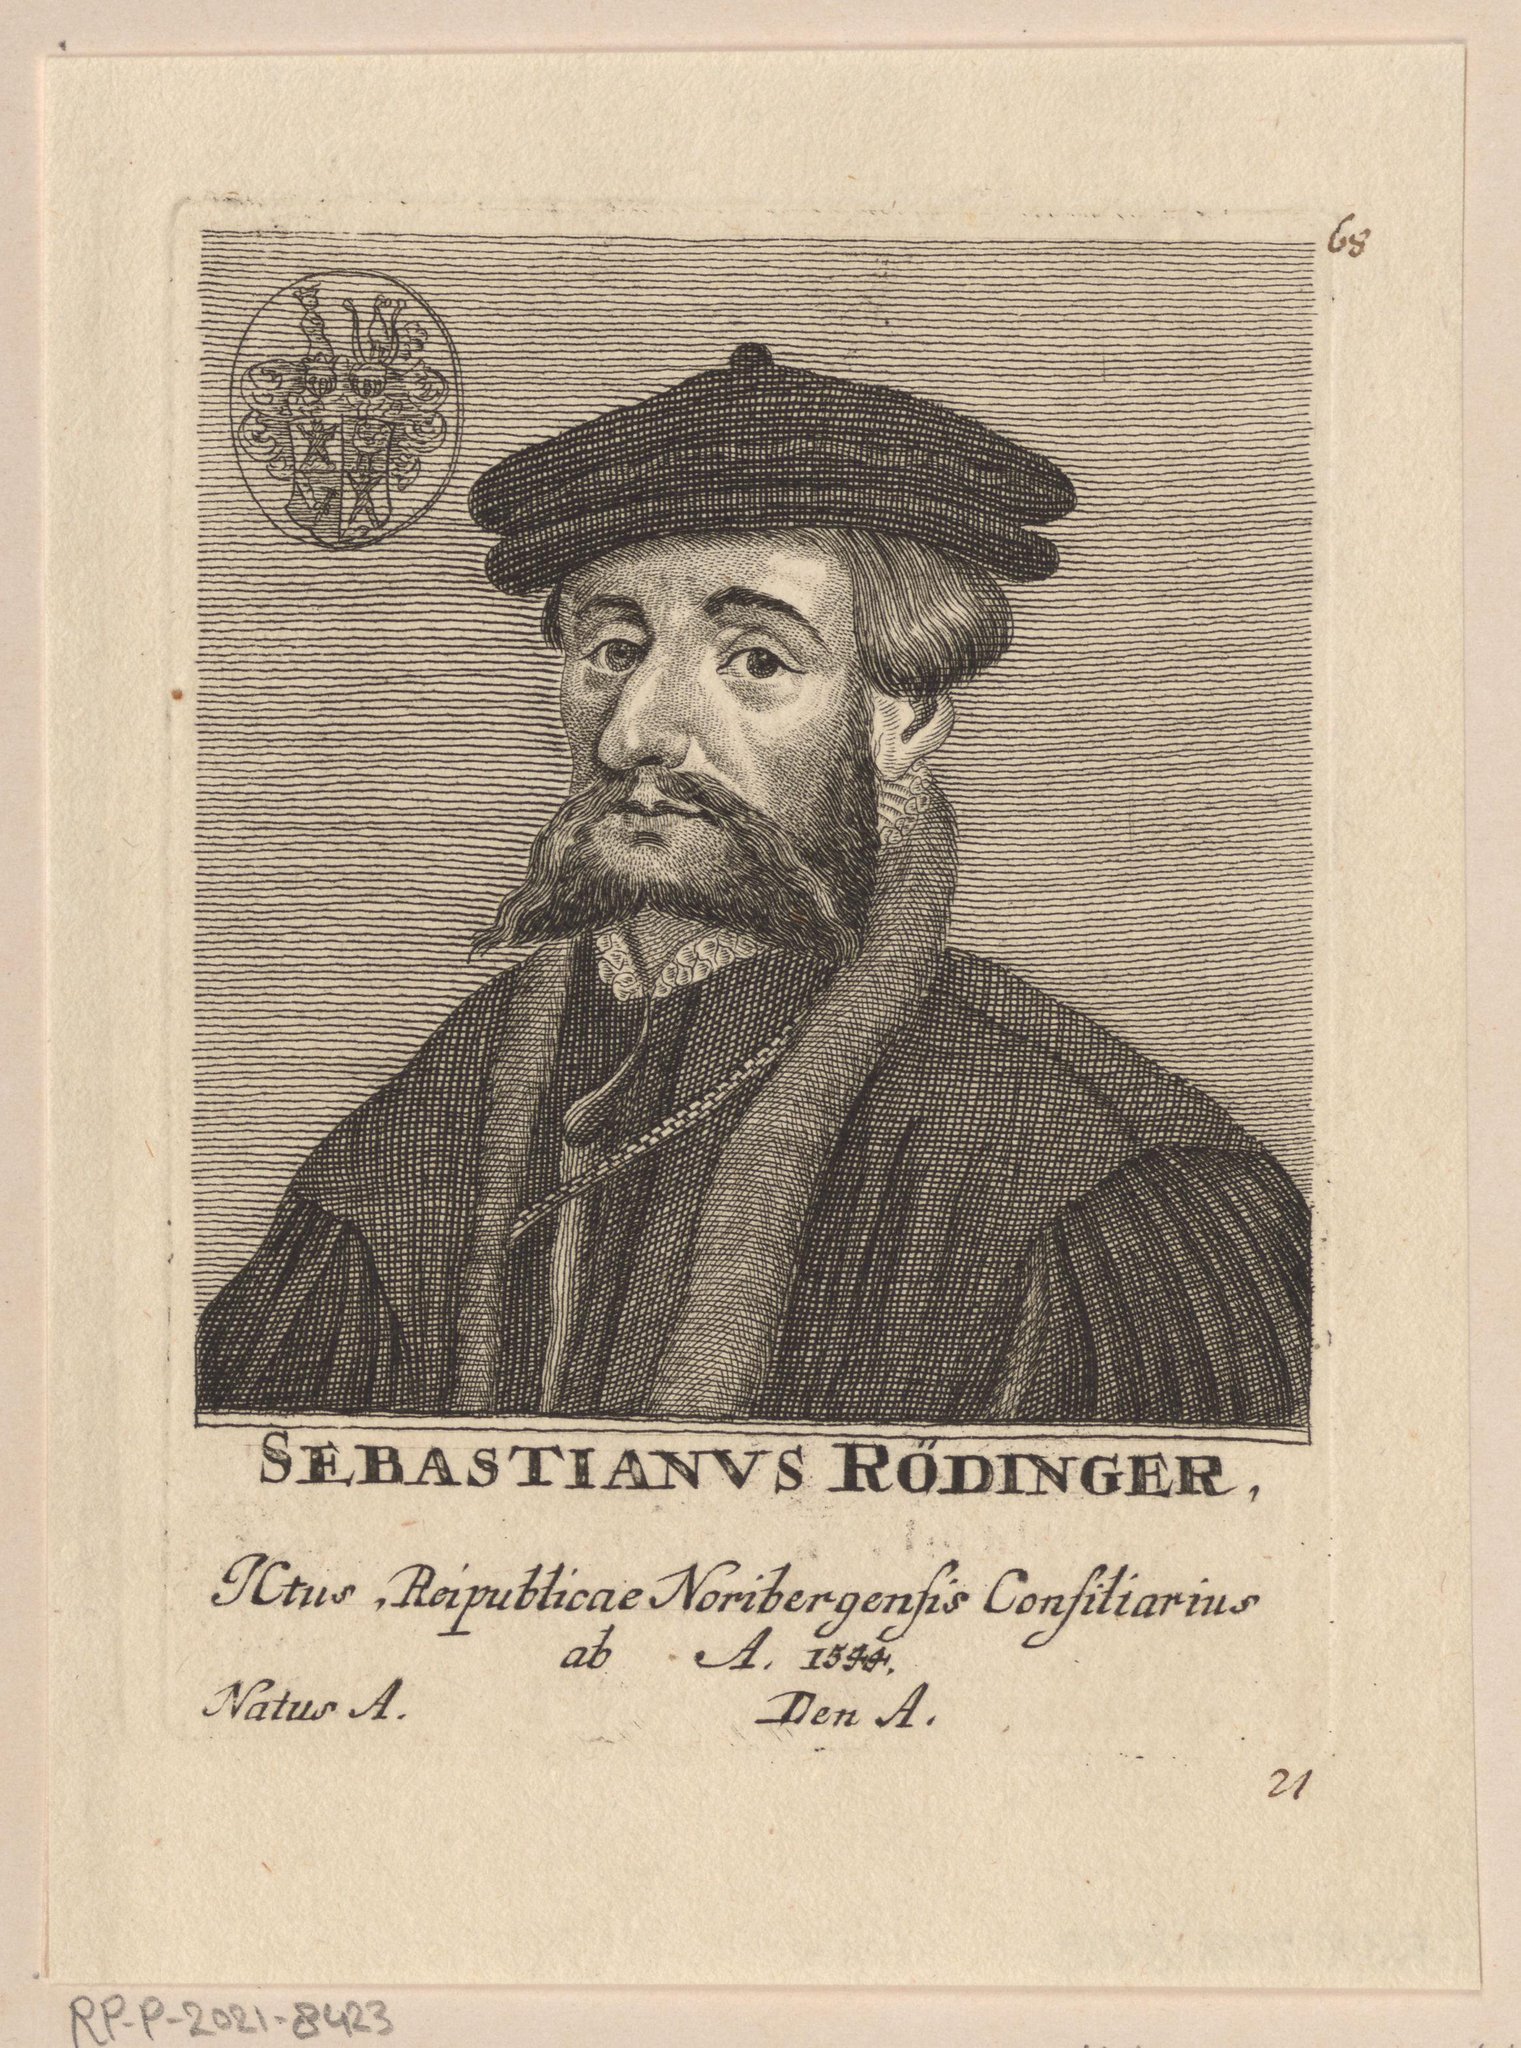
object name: print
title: Portret van Sebastian Rödinger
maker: Anonymous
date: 1723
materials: paper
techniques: engraving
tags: historical persons, armorial bearing, heraldry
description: Prent mogelijk uit: Rothscholtz, Friedrich. Icones consiliariorum de illustri republica Noribergensi (...). Neurenberg en Altdorf: erven Johann Daniel Tauber, 1723.